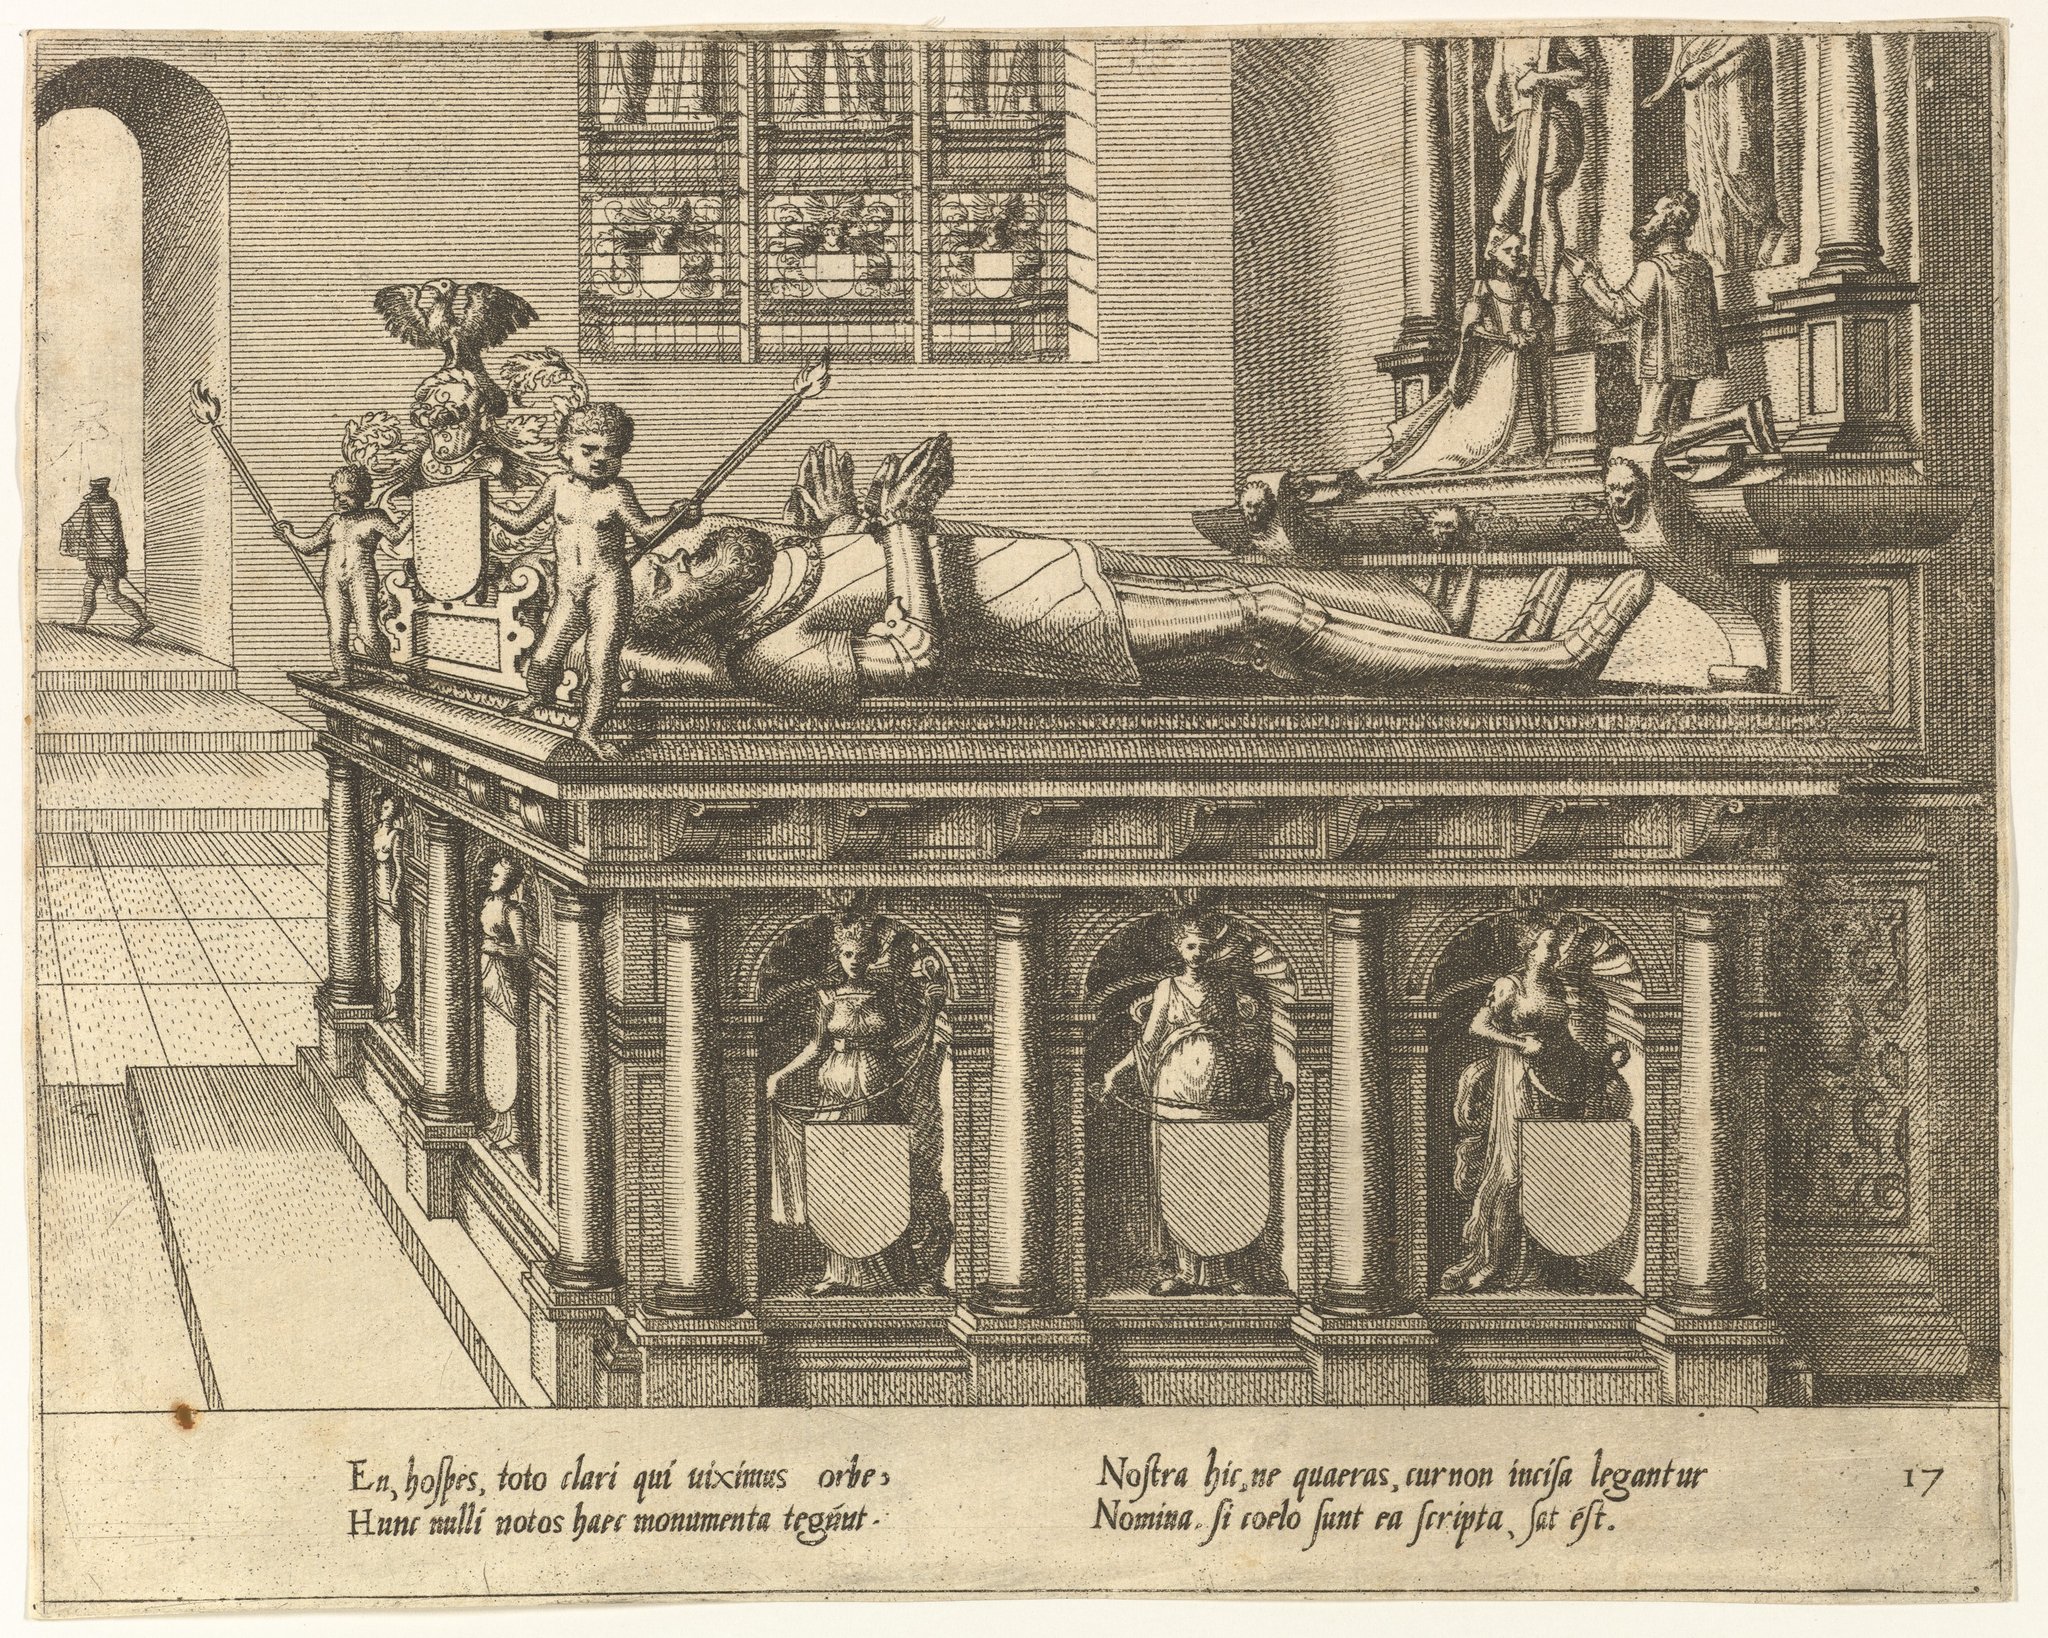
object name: collection ornament architecture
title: Cœnotaphiorum (17)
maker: hans vredeman de vries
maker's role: artist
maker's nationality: netherlandish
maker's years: 1527-1606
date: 1563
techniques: etching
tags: men,women,coat of arms